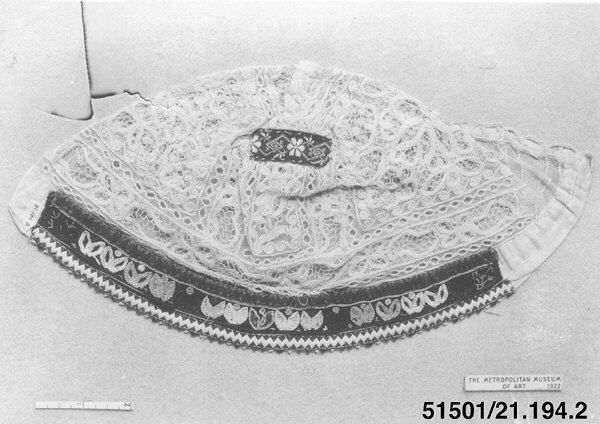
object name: cap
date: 1801-1900